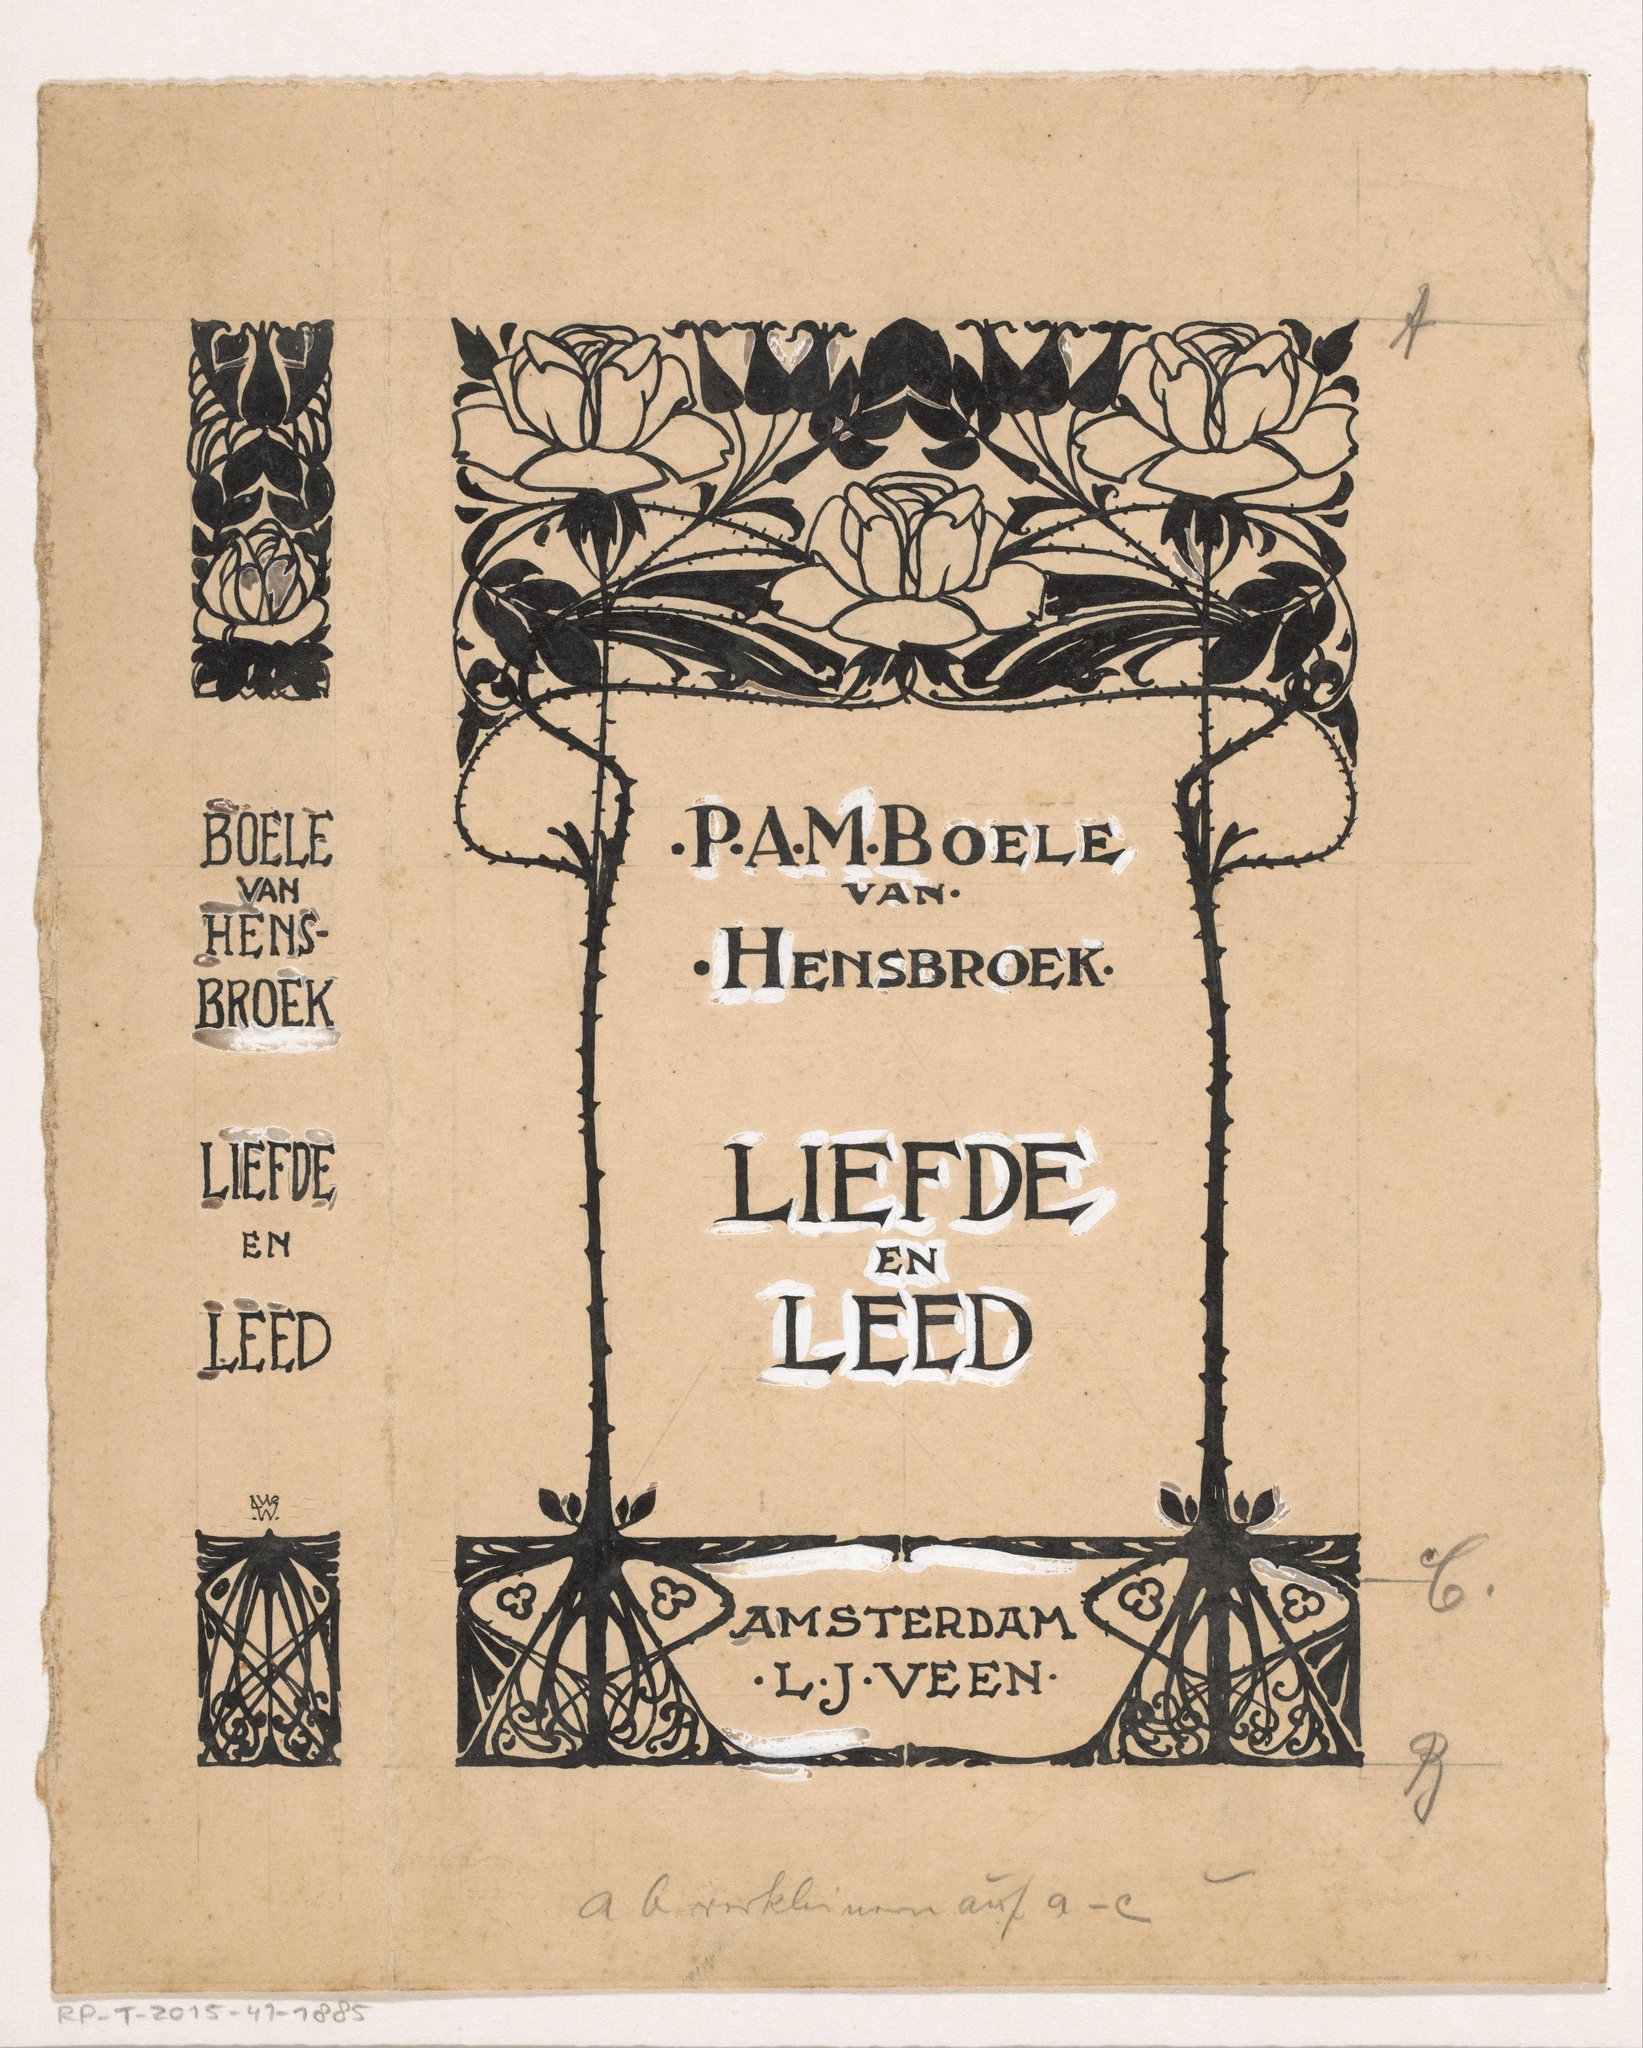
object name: drawing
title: Bandontwerp voor: P.A.M. Boele van Hensbroek, Liefde en leed, 1903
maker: willem wenckebach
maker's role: designer, draughtsman, painter, print maker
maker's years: 1860-1937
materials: paint, ink, paper, pencil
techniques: brush, pen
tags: flowers ~ ornament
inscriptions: collector's mark: Lugt 2228, monogram:, :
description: Boektitel en auteursnaam met daarboven een motief van bloeiende rozen met bladeren. De takken van de rozen lopen verticaal naar beneden over de band en eindigen in een verzameling gestileerde wortels.